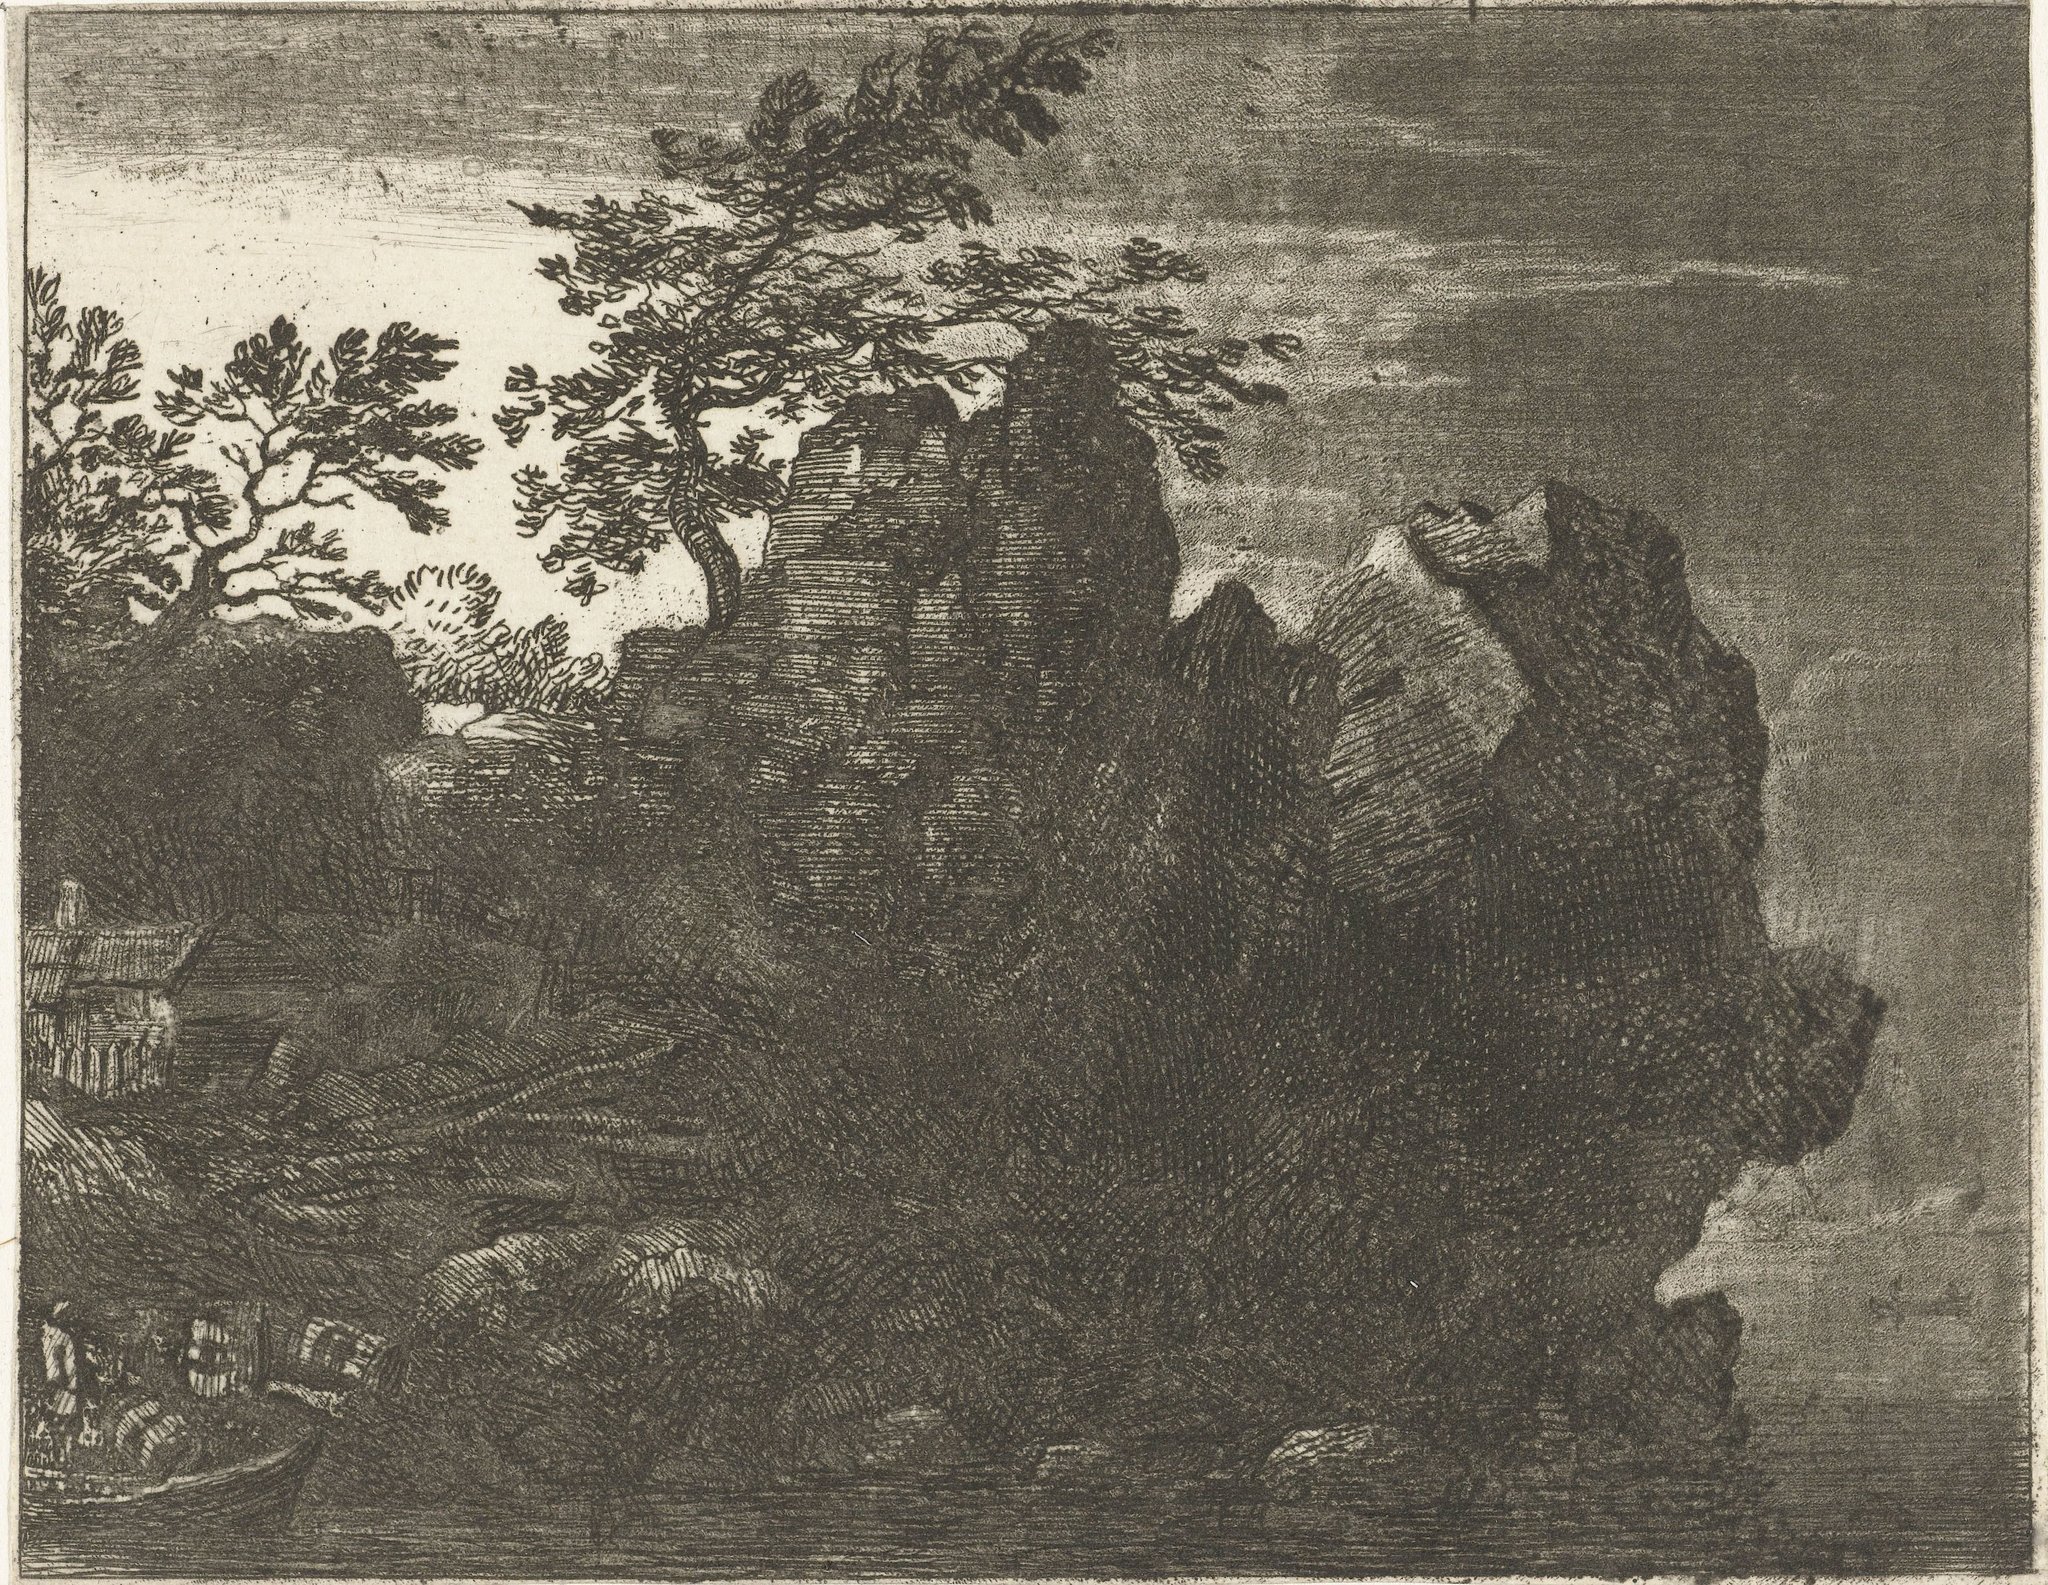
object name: print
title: De grote rots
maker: allaert van everdingen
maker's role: draughtsman, painter, print maker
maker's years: 1621-1675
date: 1631-1675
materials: paper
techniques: etching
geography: netherlands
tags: rock-formations (+ landscape with figures, staffage)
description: Gezicht op een grote rotspartij aan het water, bij nacht. Op de voorgrond een kleine sloep en enkele houten tonnen.